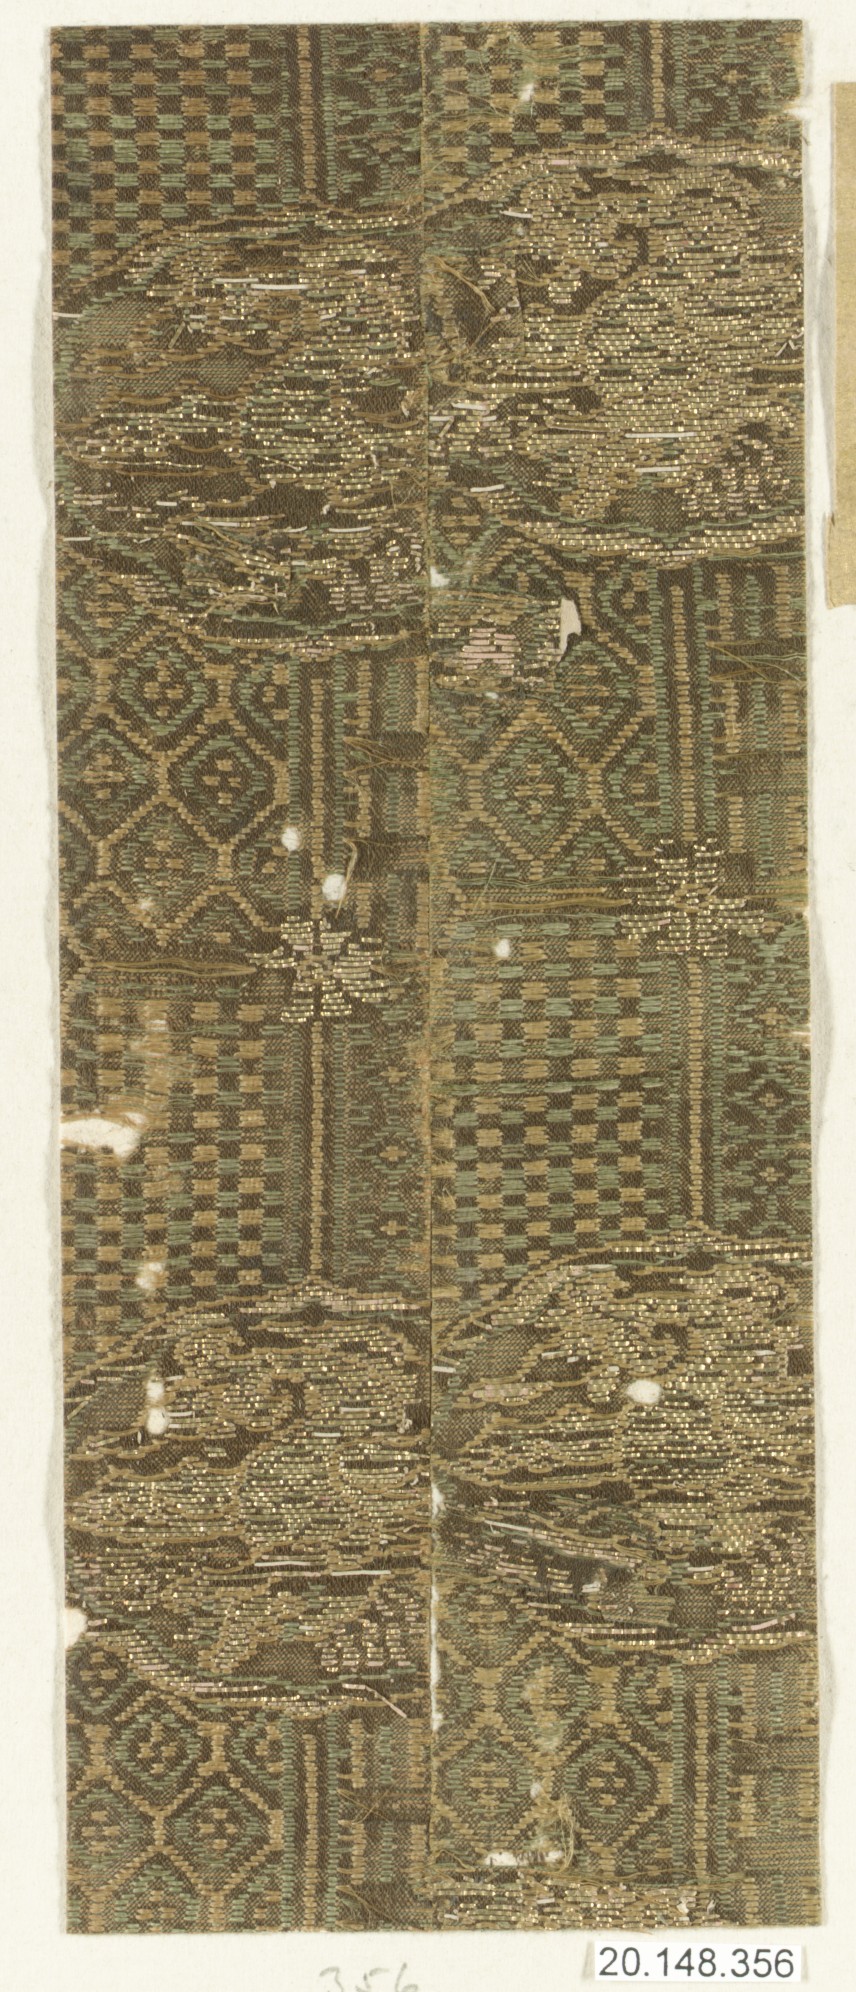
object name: piece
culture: japanese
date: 1701-1800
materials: silk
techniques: compound weave